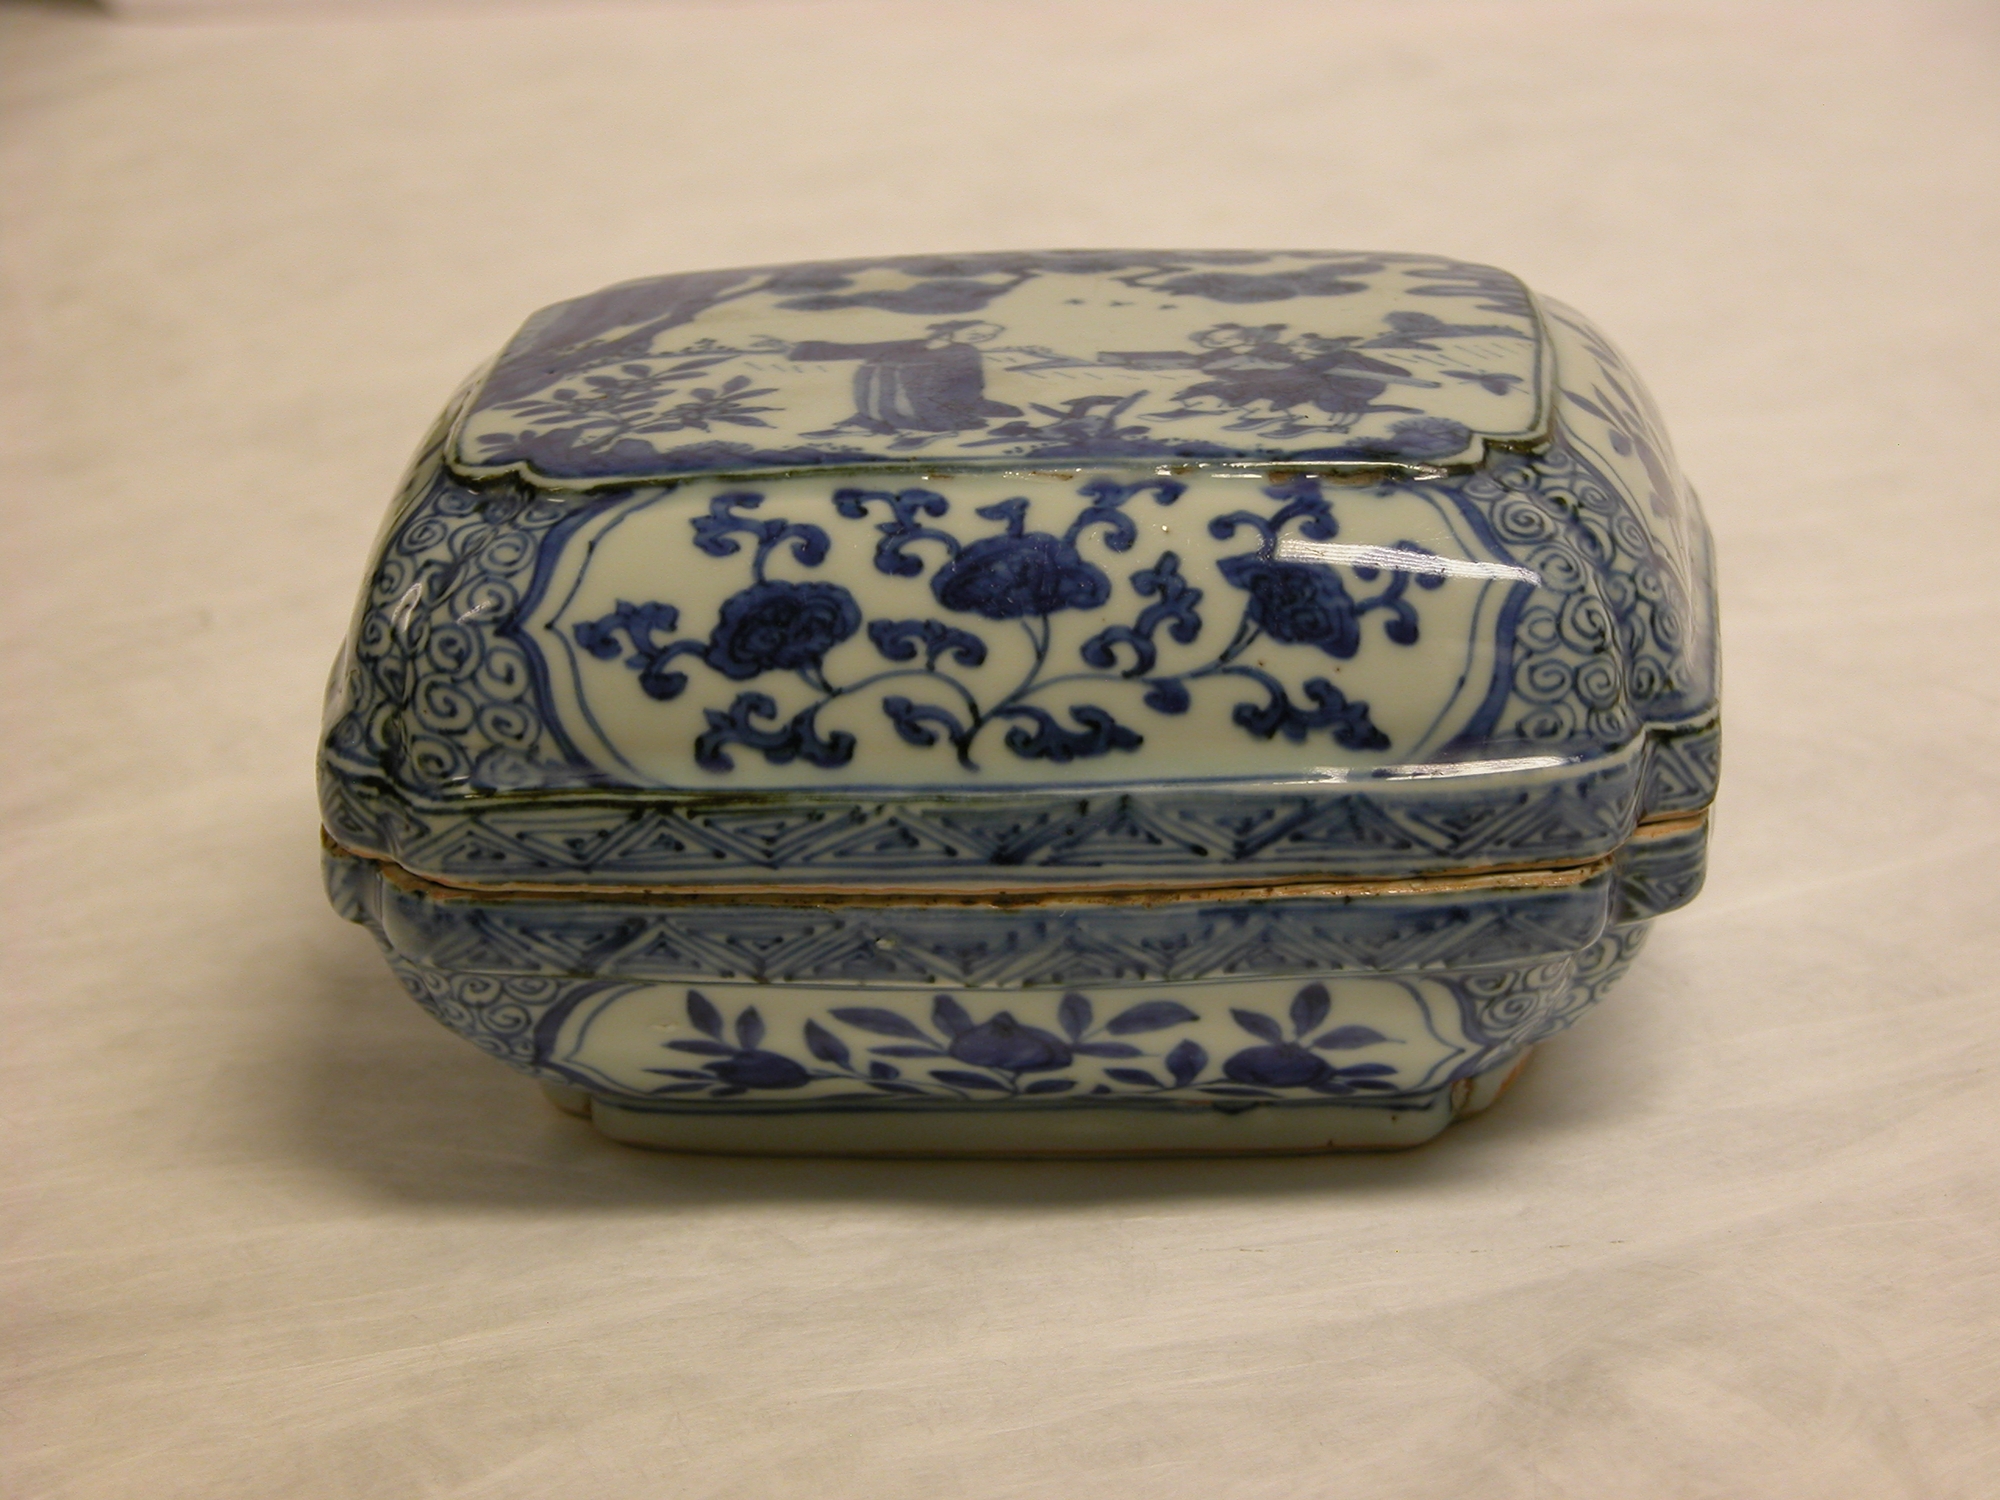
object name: covered box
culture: chinese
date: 1573-1620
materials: porcelain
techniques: painting, underglaze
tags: human figures,flowers